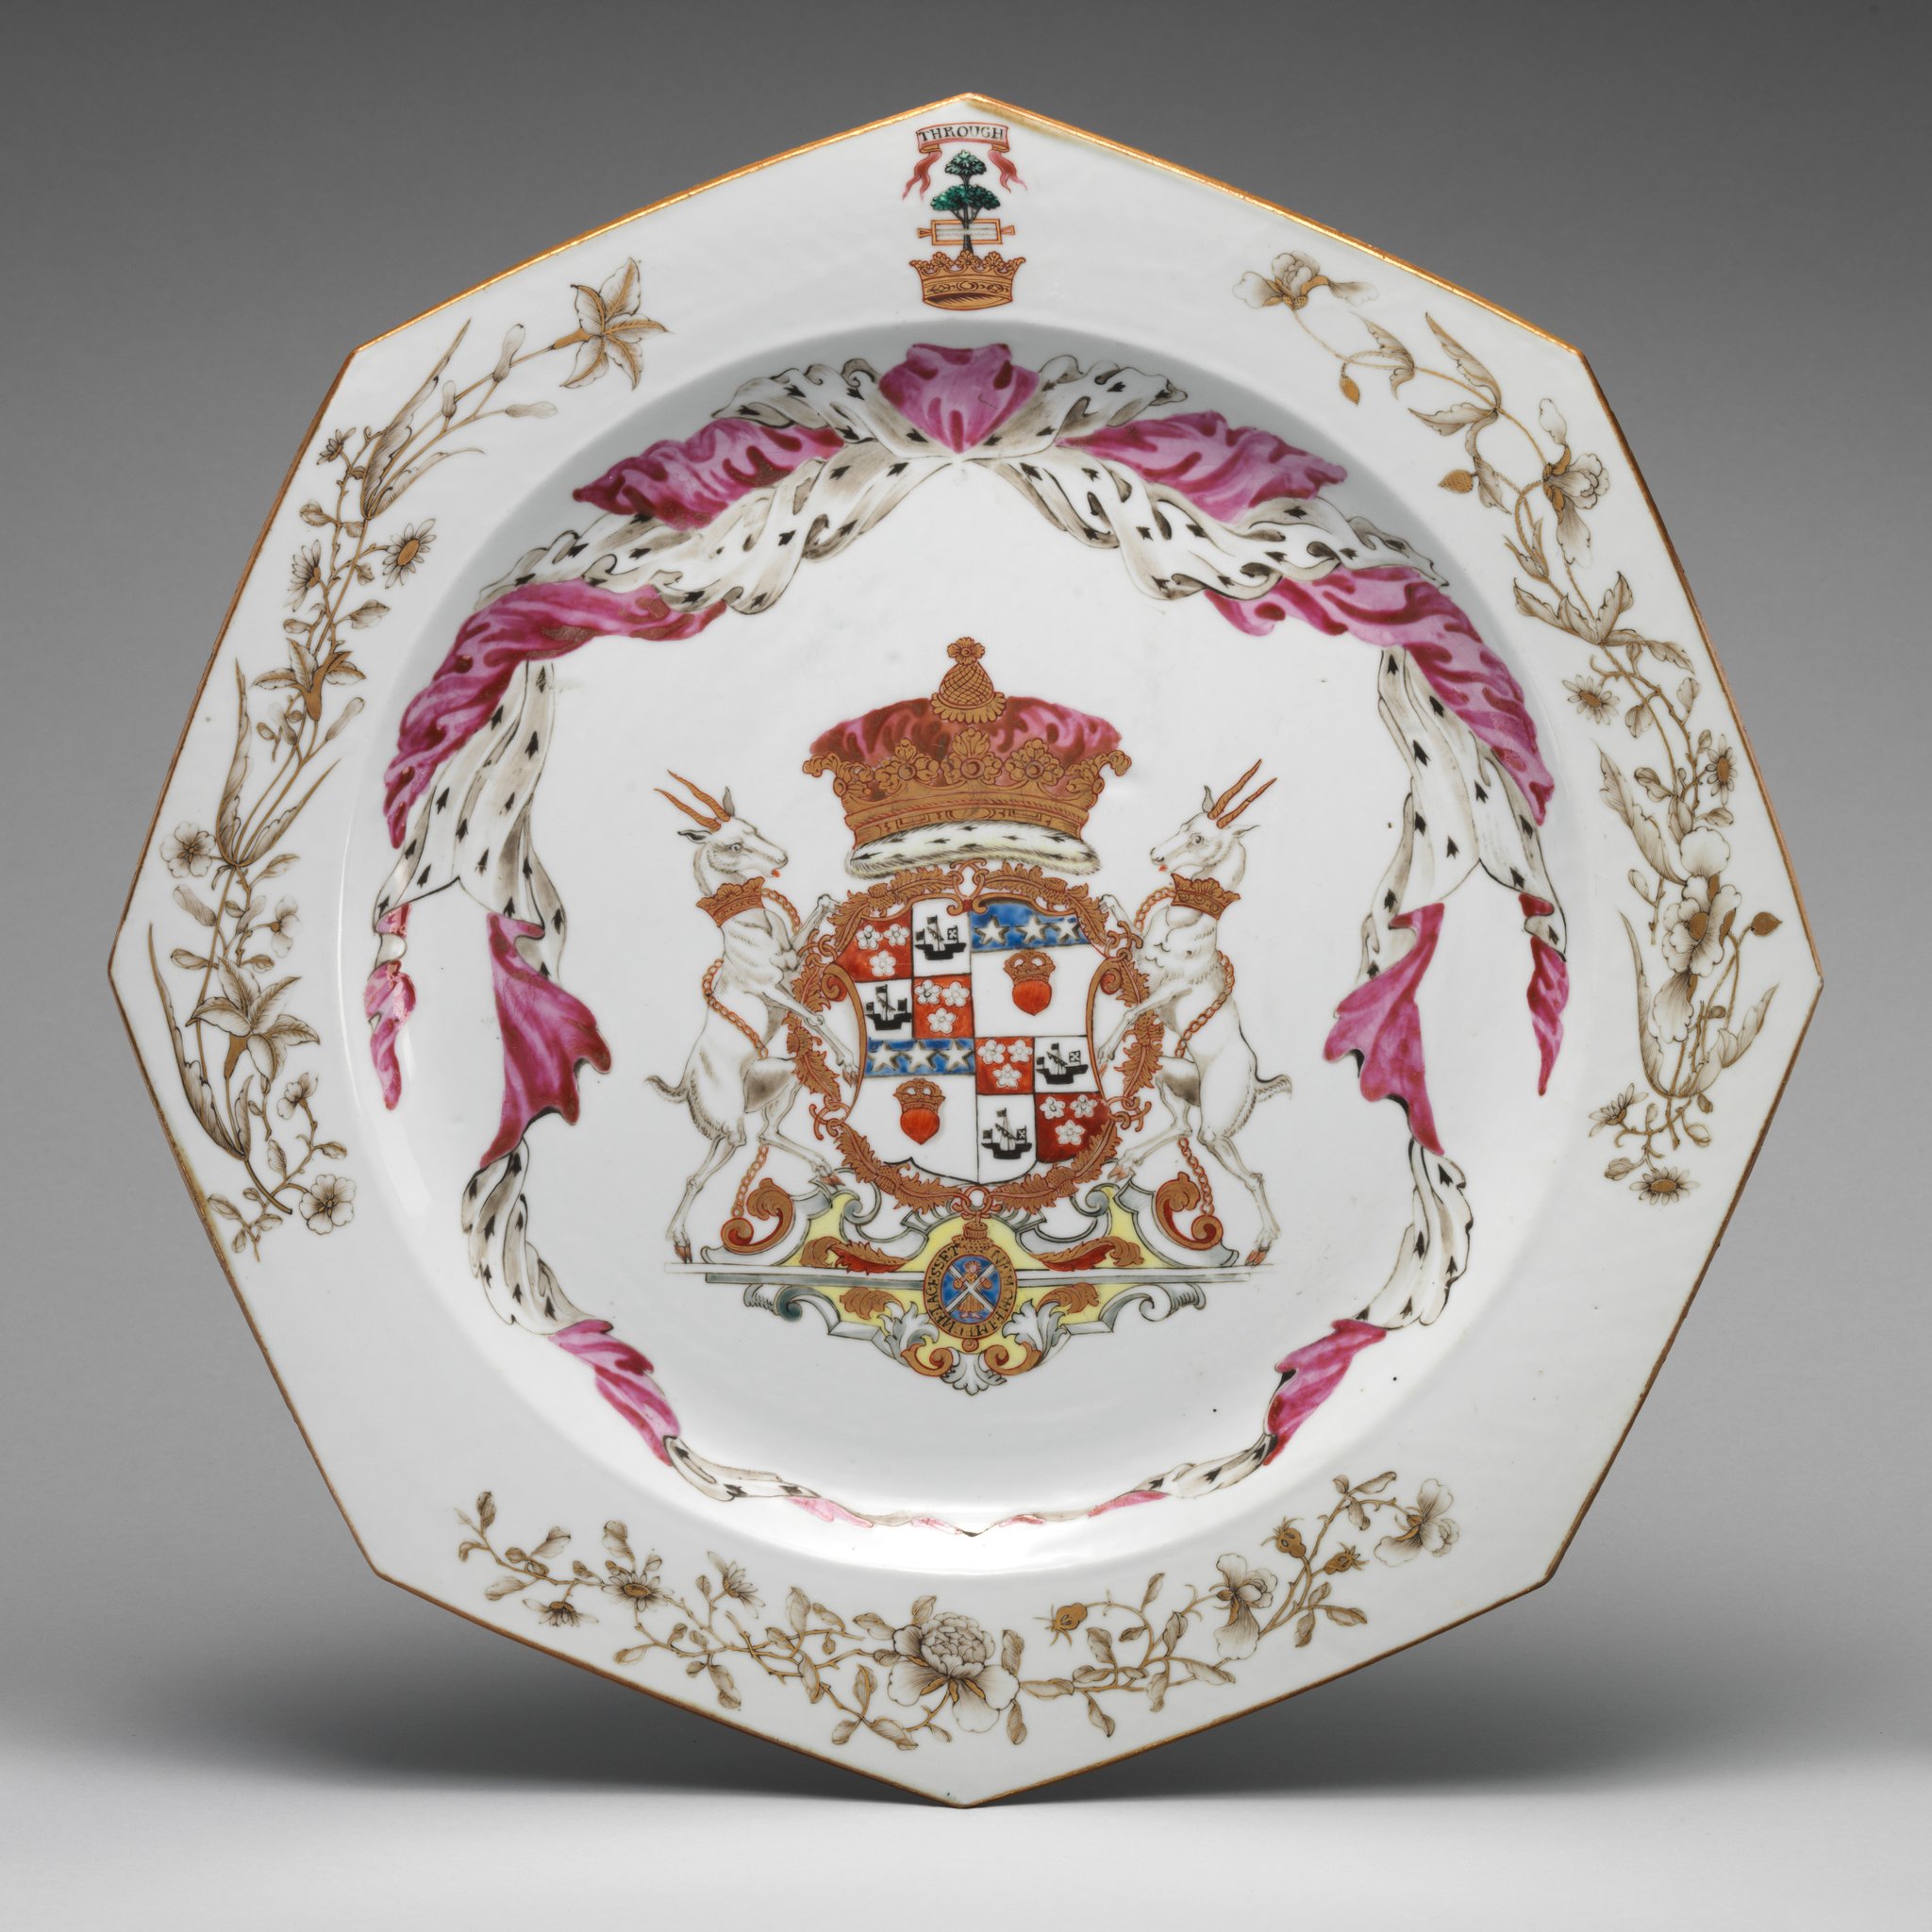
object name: dish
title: Dish (part of a service)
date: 1737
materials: hard paste porcelain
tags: flowers,coat of arms